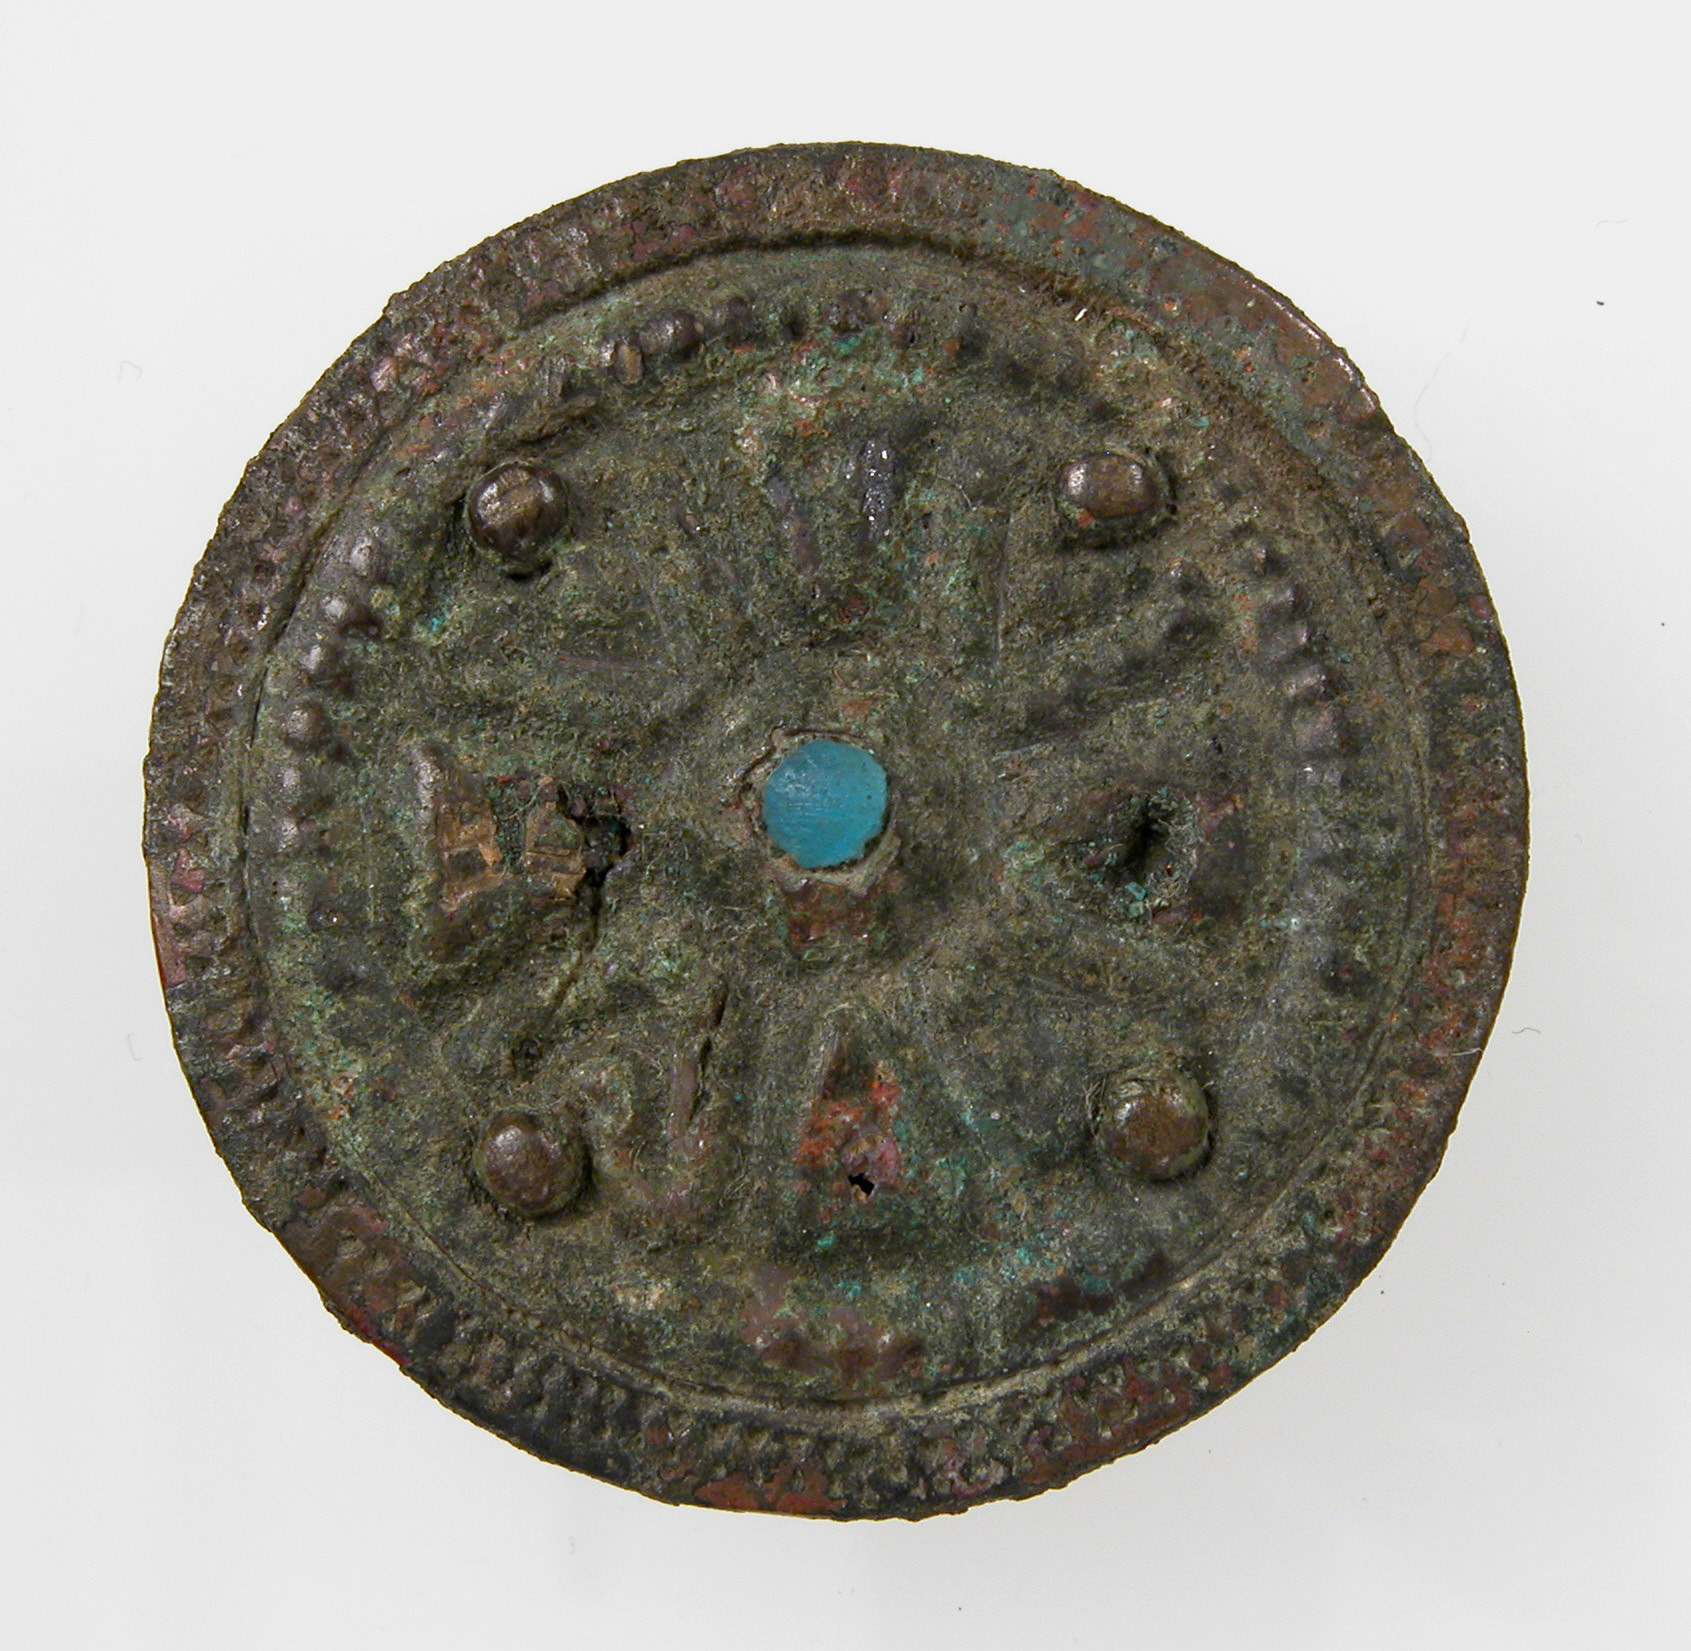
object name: brooch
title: Disk Brooch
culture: frankish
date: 567-633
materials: copper alloy, glass, iron, paste